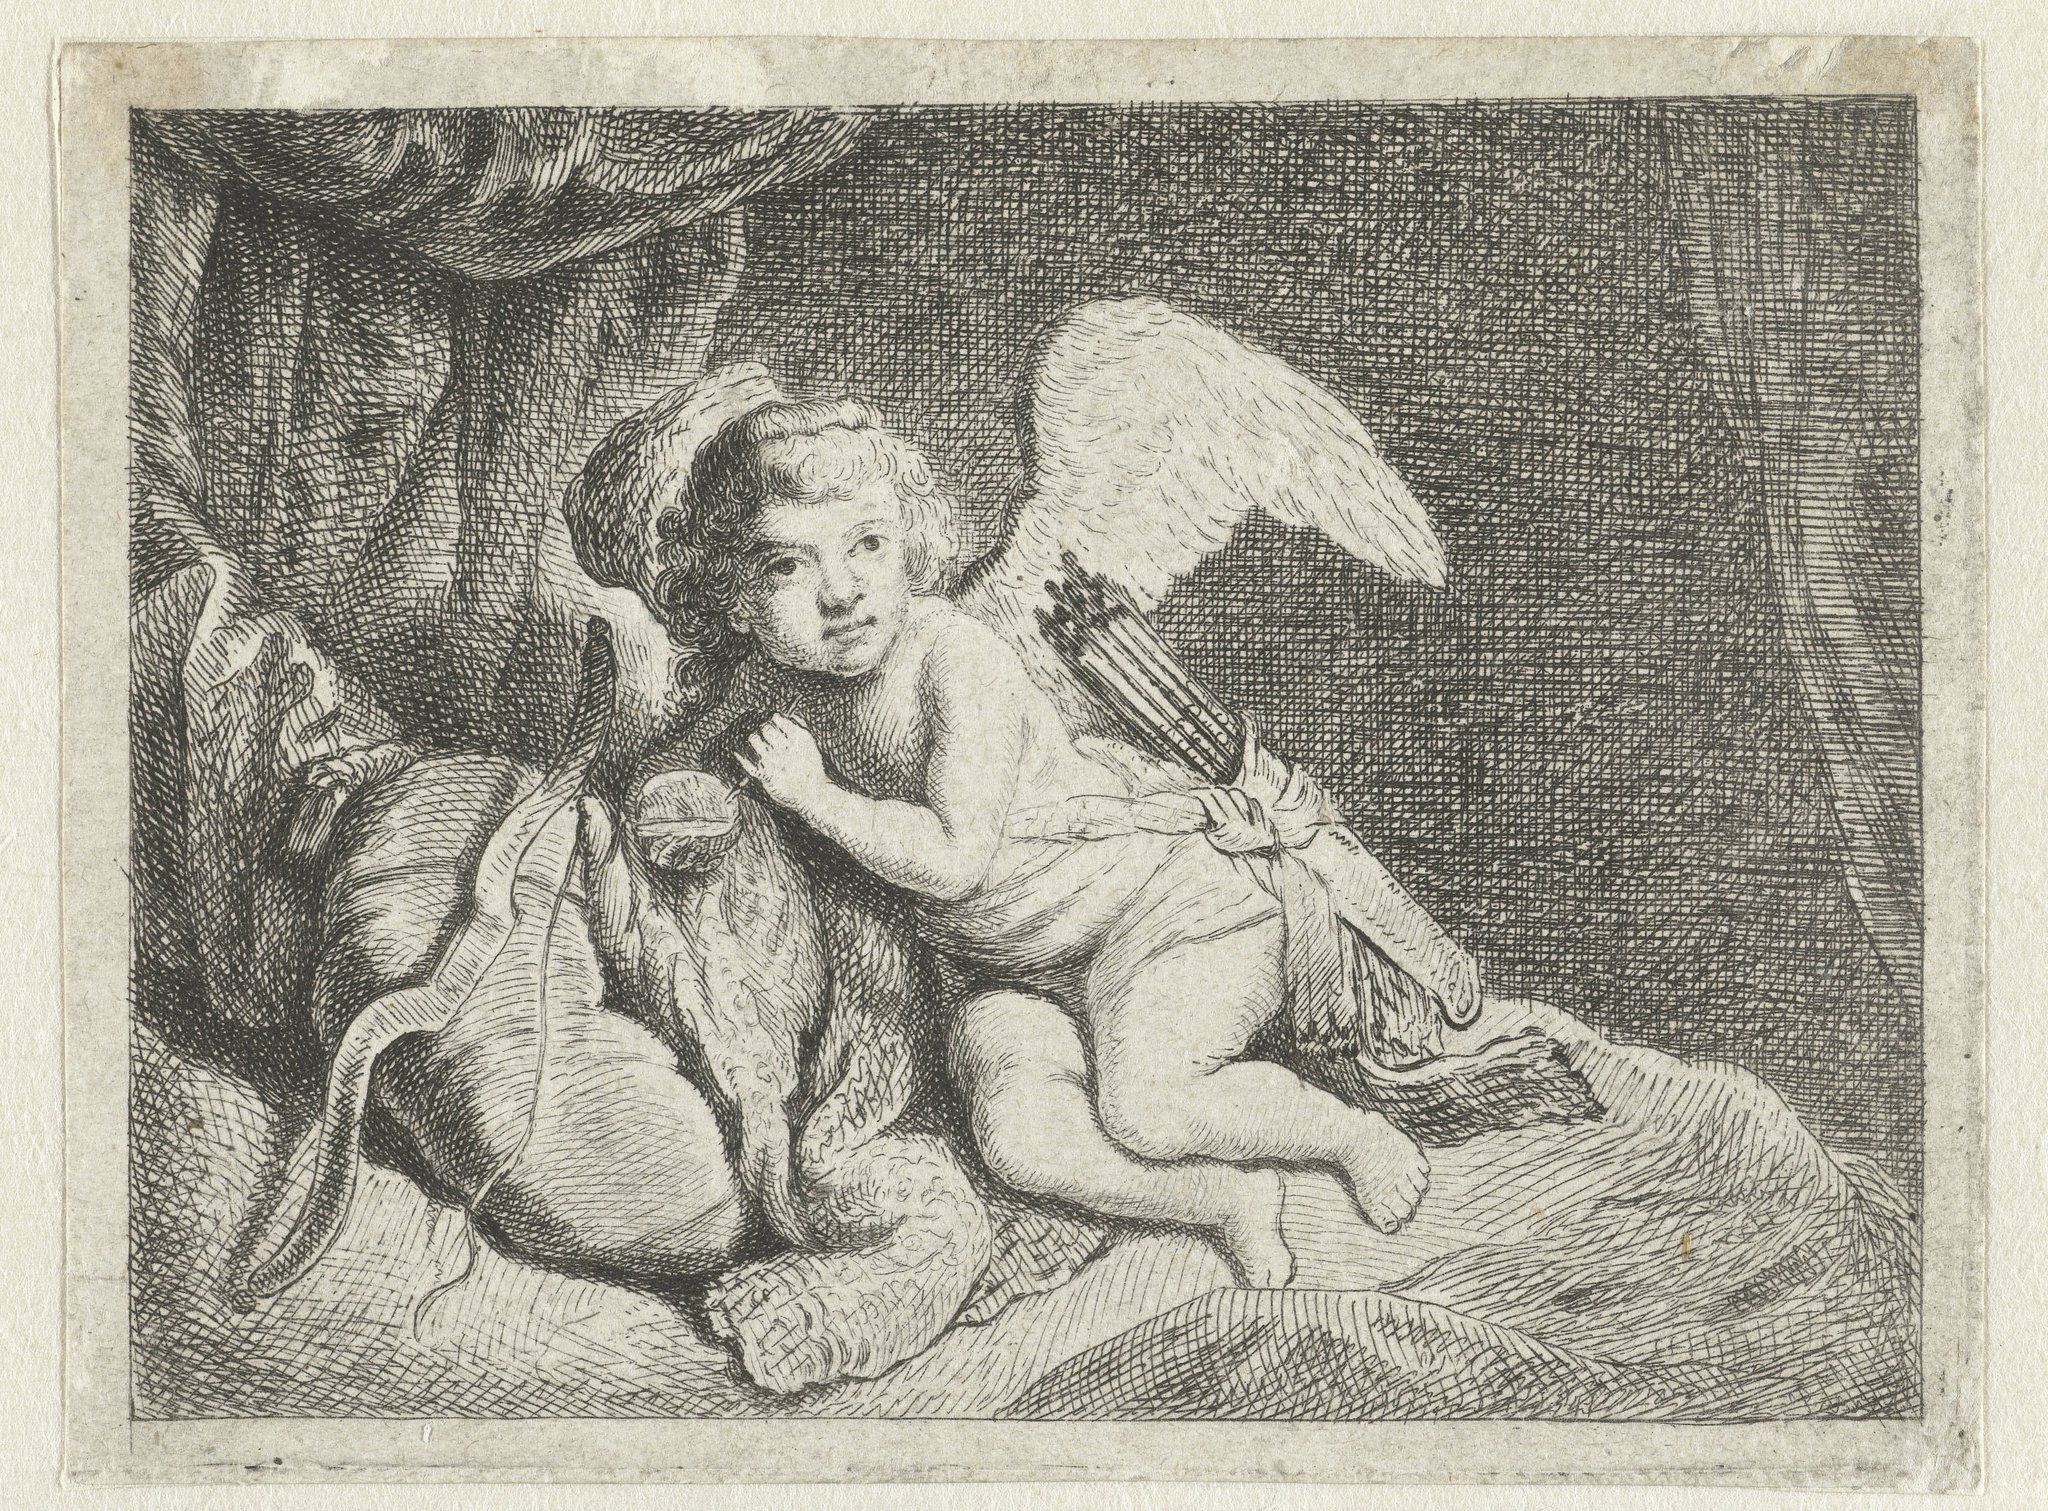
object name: print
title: Rustende Amor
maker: pierre françois basan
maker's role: print maker, publisher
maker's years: 1723-1797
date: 1733-1797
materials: paper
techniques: etching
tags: (story of) cupid, amor (eros)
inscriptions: collector's mark: Lugt 2228